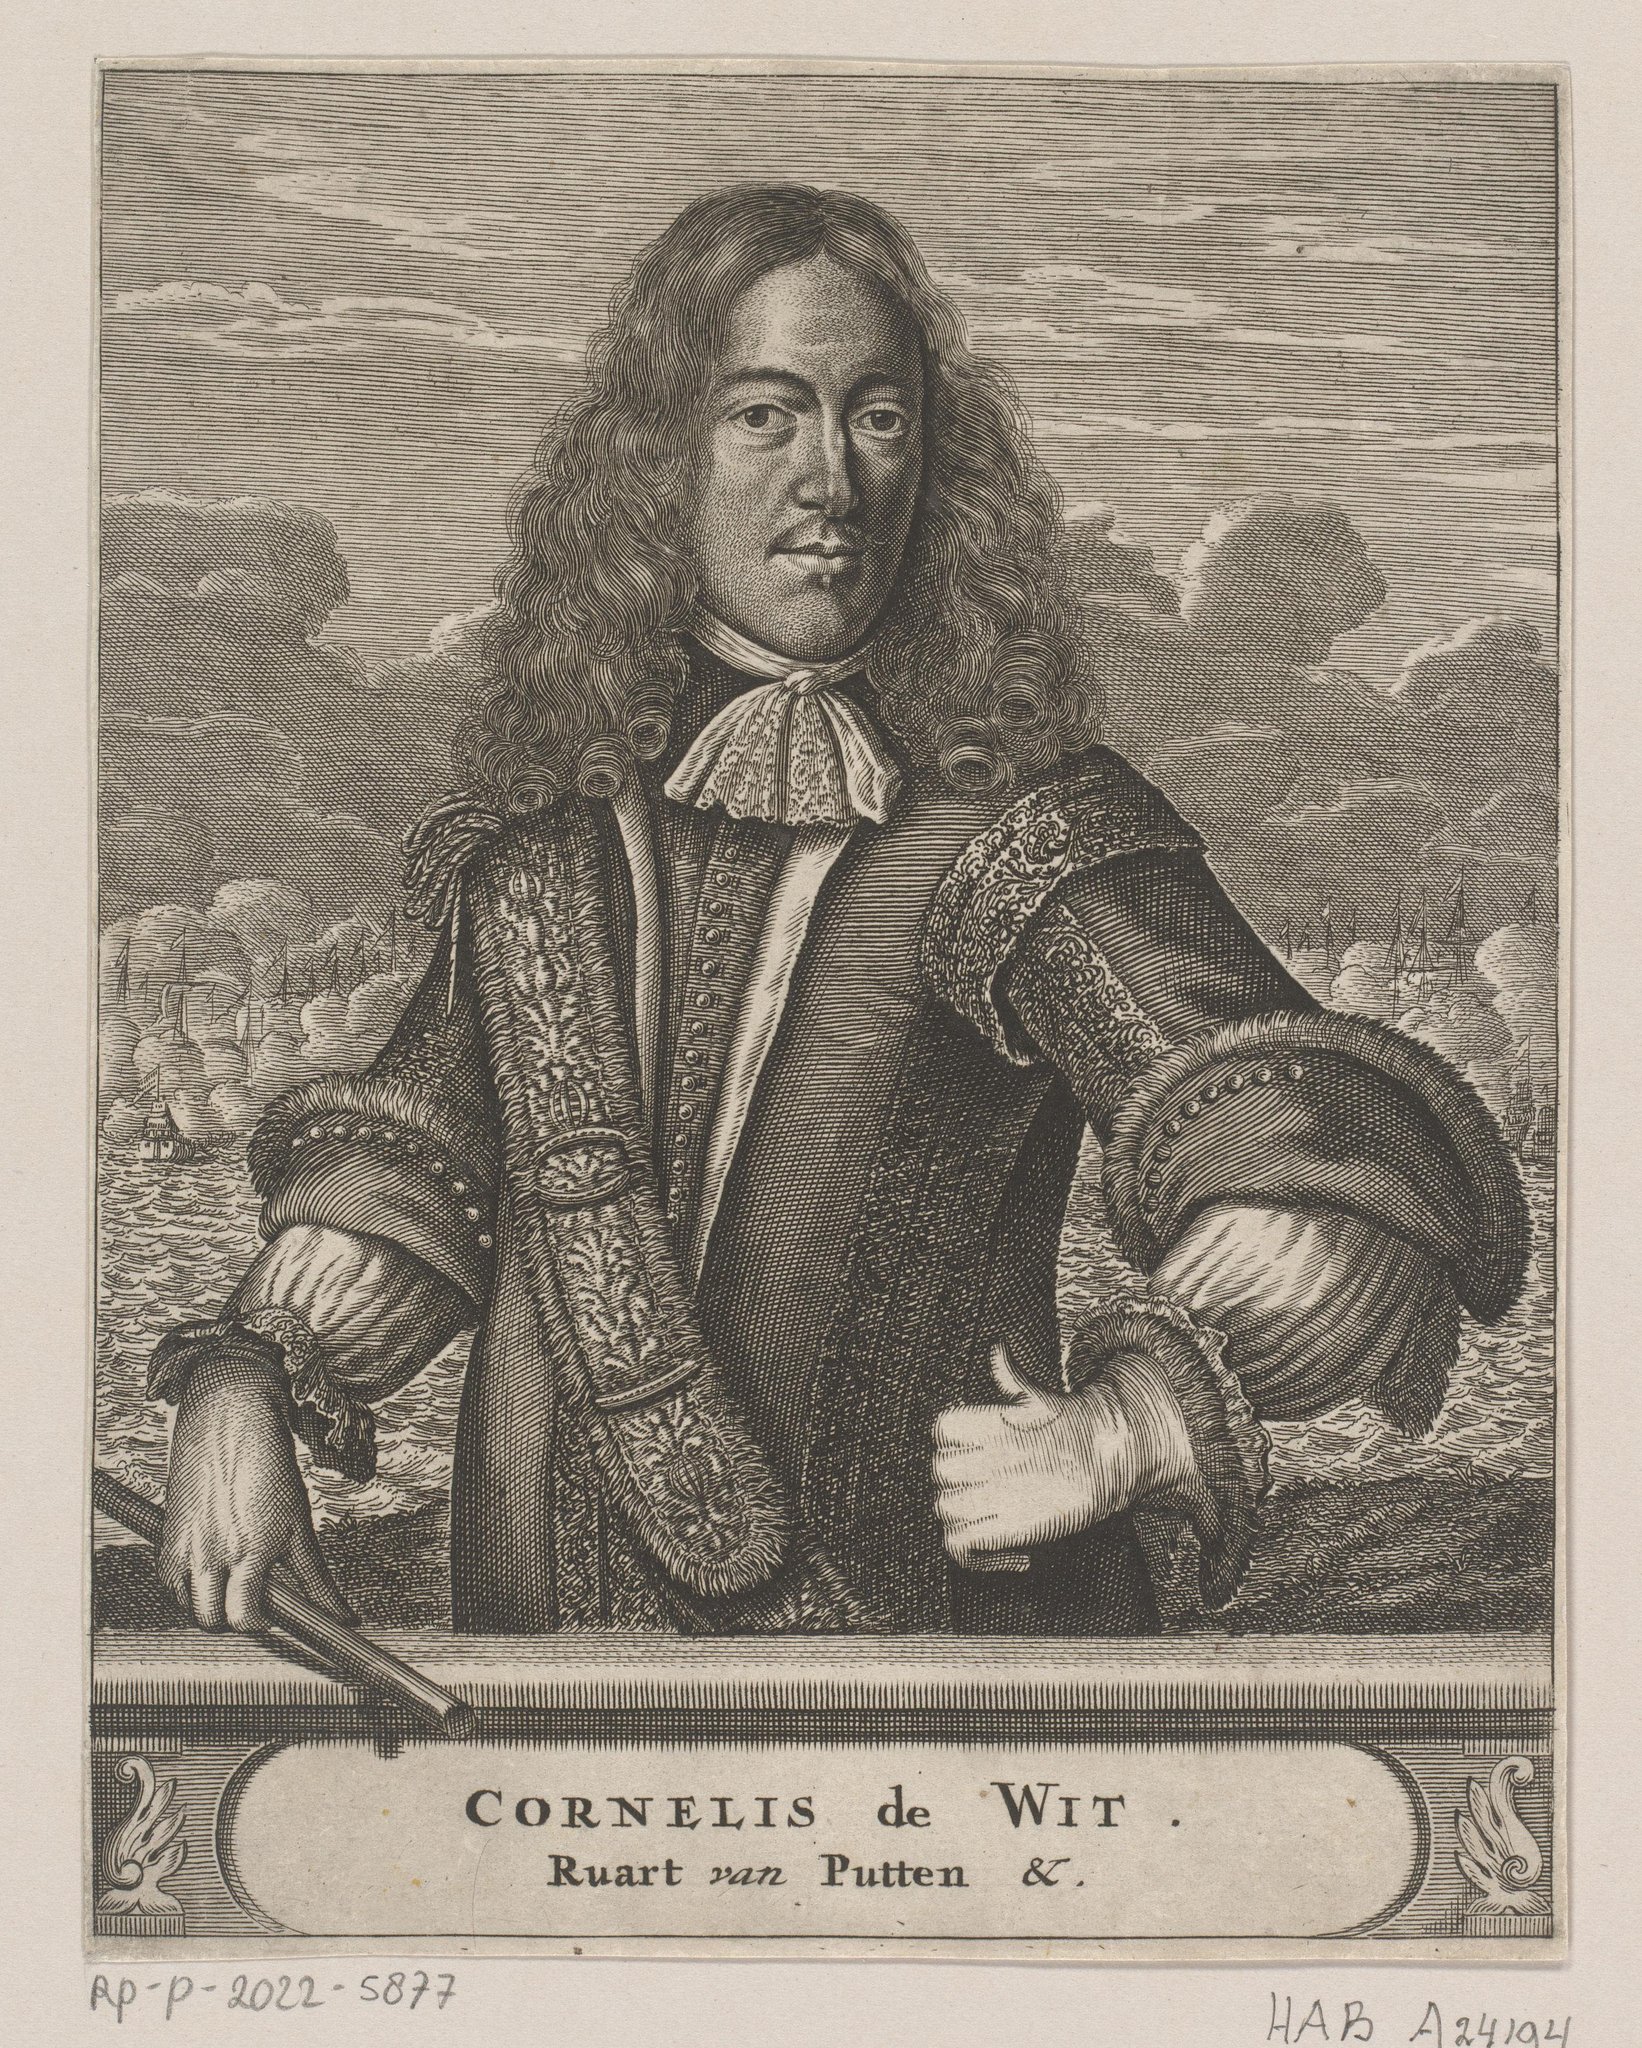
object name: print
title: Portret van Cornelis de Witt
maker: christiaan hagen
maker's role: draughtsman, print maker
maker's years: 1635-1707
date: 1675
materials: paper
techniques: engraving, etching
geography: amsterdam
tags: the hague, cornelis de witt, historical persons, governor, etc. of province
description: Prent waarschijnlijk uit: Bosch, Lambertus van den. Tooneel des oorlogs, opgerecht in de Vereenigde Nederlanden. Amsterdam: Jacob van Meurs en Johannes van Someren, 1675, dl. 1-2.